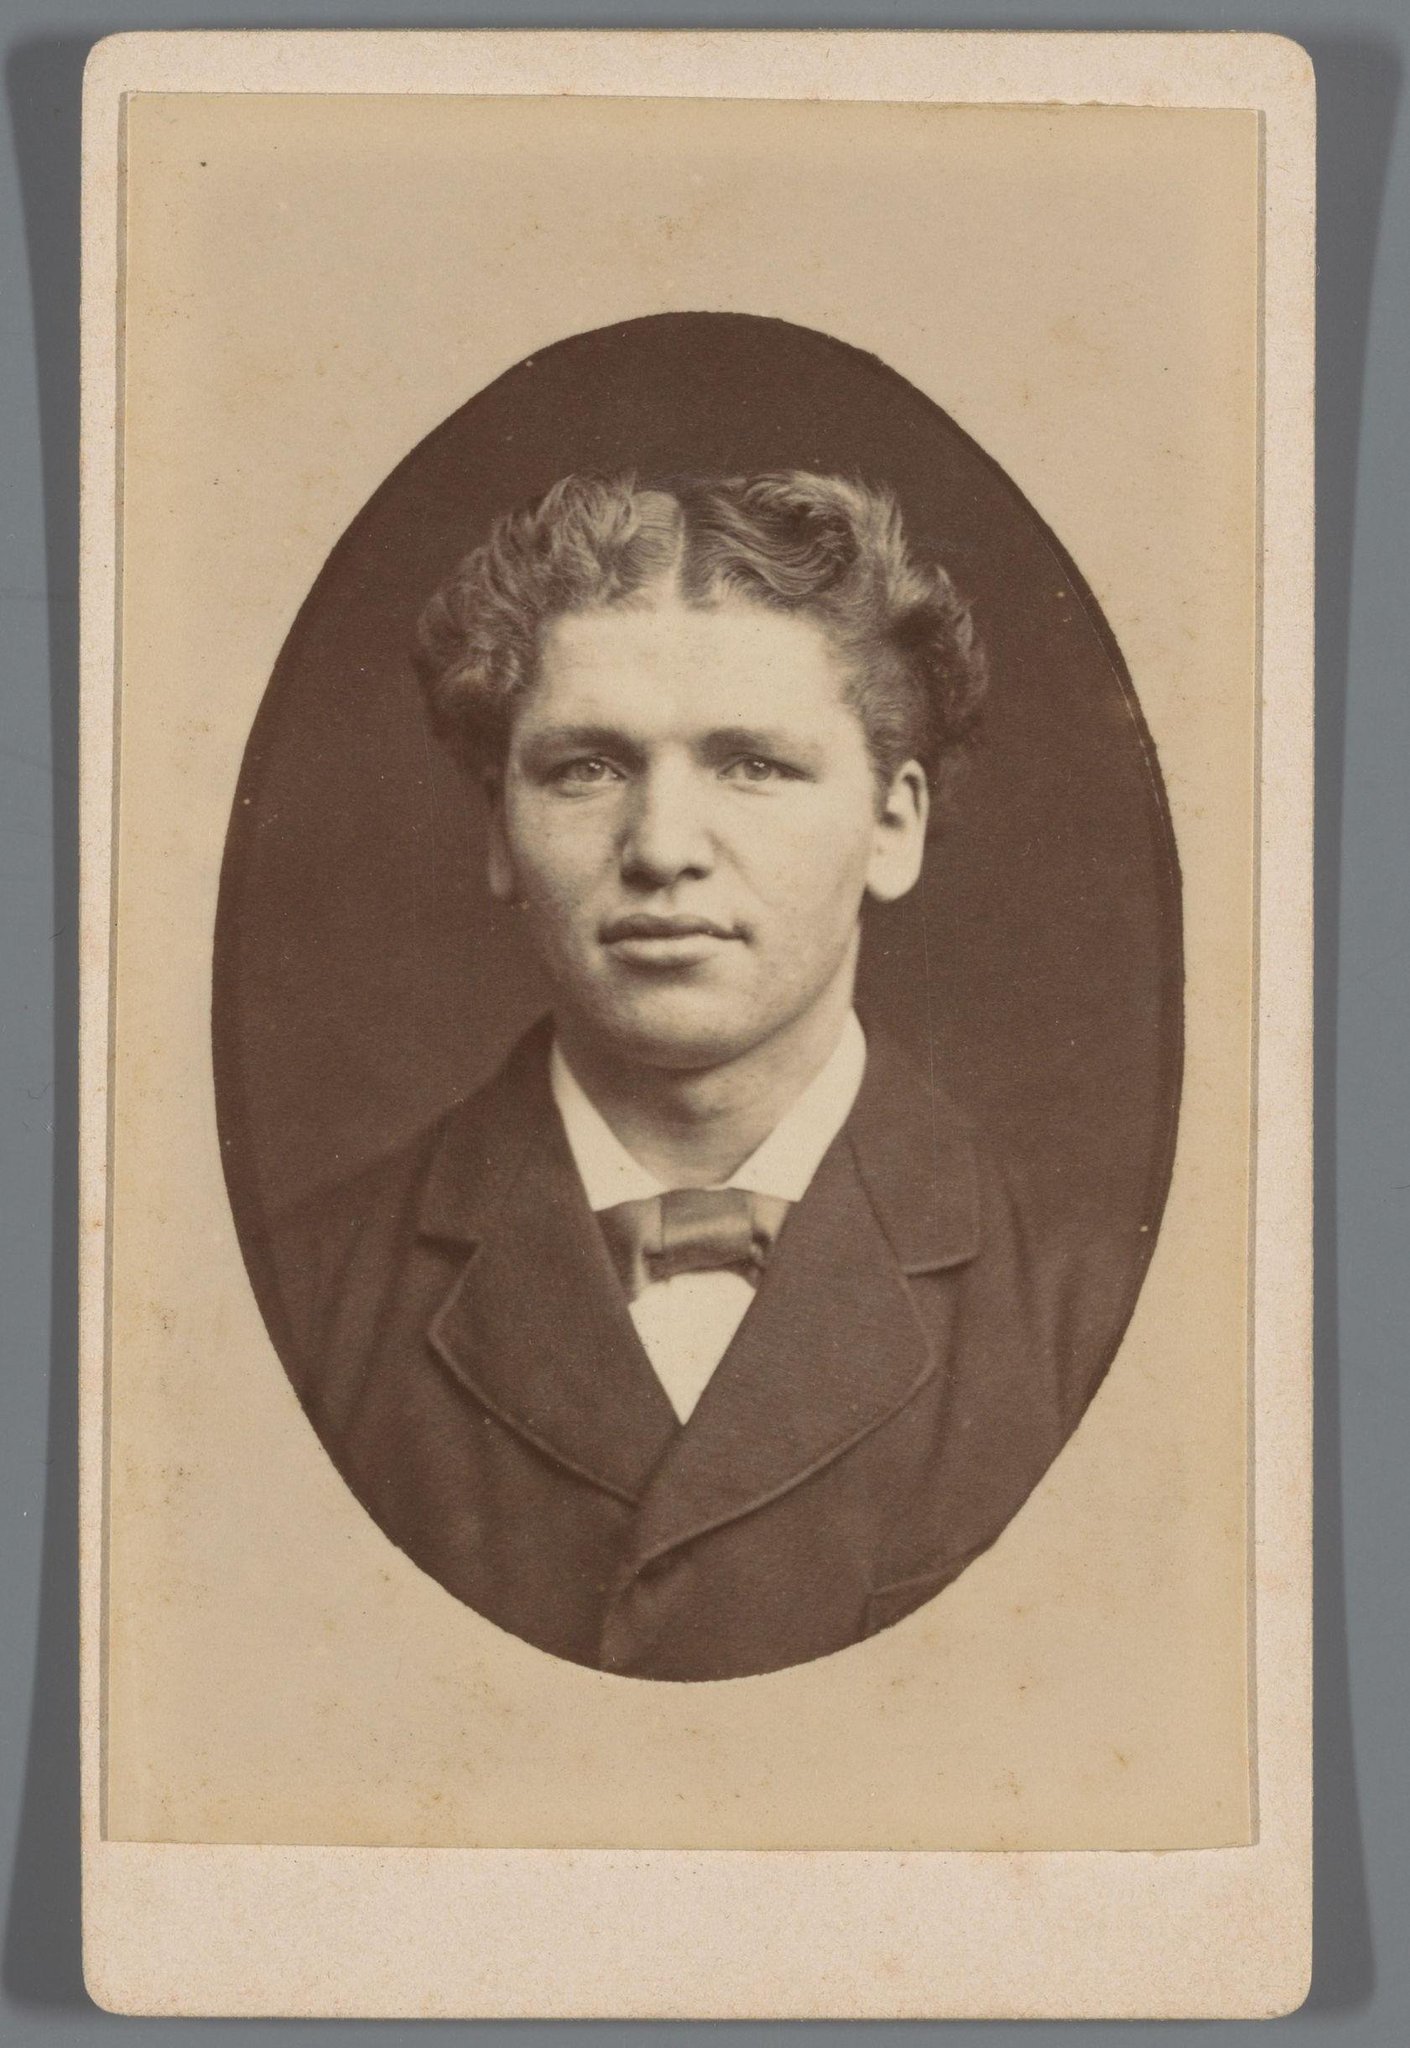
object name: photograph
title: Portret van een onbekende man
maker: willem gerhardus kuijer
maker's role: fotograaf, hoffotograaf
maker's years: 1834-1899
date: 1867-1880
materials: cardboard, celluloid, paper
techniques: albumen print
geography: amsterdam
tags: adult man, anonymous historical person portrayed, amsterdam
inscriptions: inscription: ‘W.G. Kuijer/ Photograaph/ Amsterdam/ Rozengracht 72.’